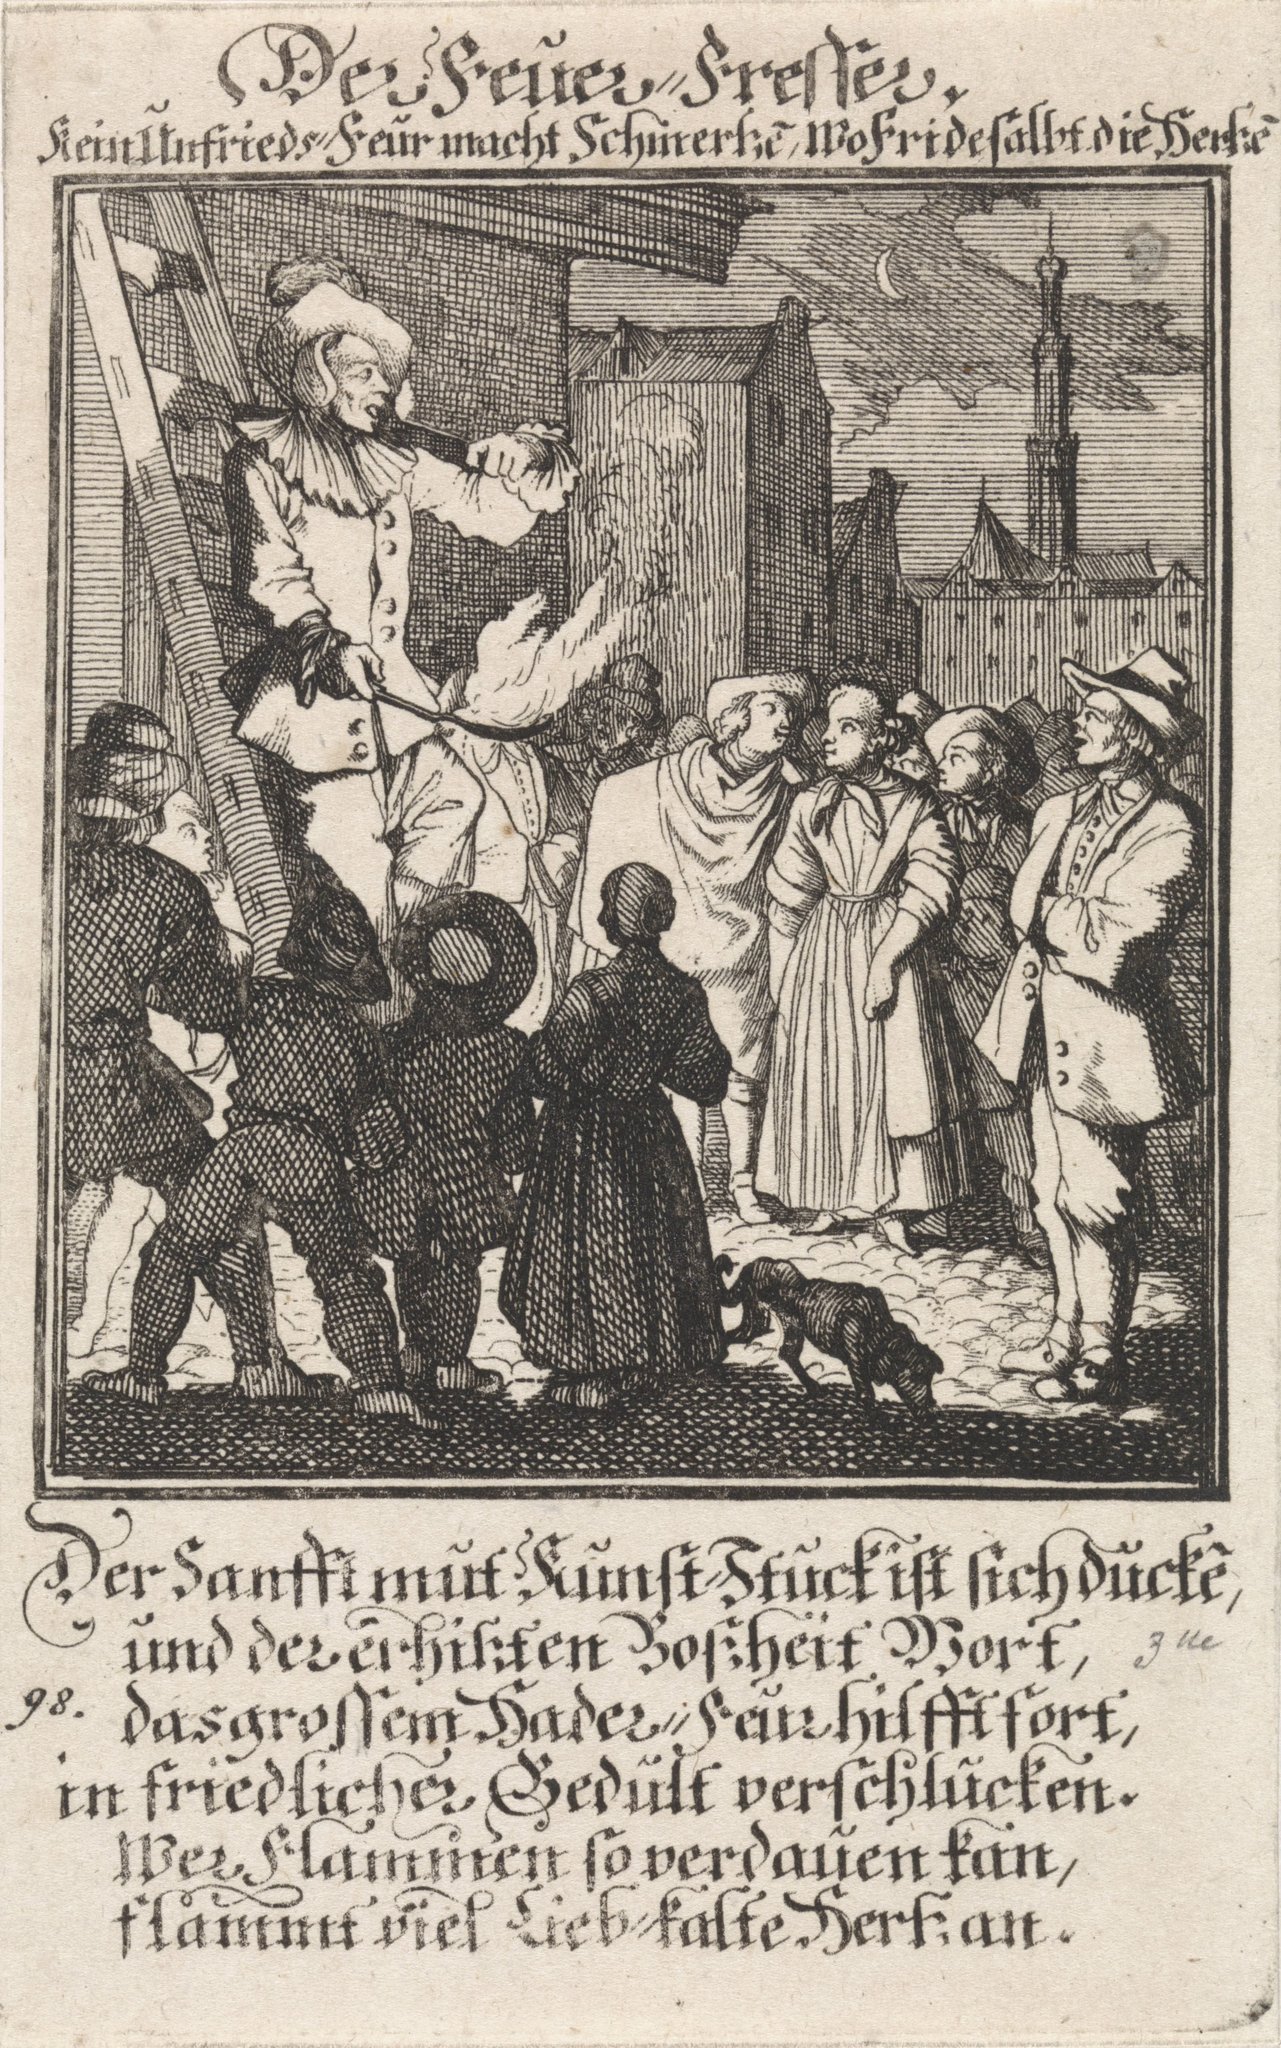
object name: book illustration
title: Vuureter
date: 1711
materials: paper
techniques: etching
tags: fire-eater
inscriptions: collector's mark: Lugt 2228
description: Illustratie uit: Sancta Clara, Abraham à. Etwas für Alle, das ist: Eine kurtze Beschreibung allerley Stands- Ambts- und Gewerbs-Persohnen (...), 3 delen (1699-1733). Würtzburg: Martin Frantz Hertz, 1711, dl. III, p. 907. Het betreft hier de tweede druk van deel III.